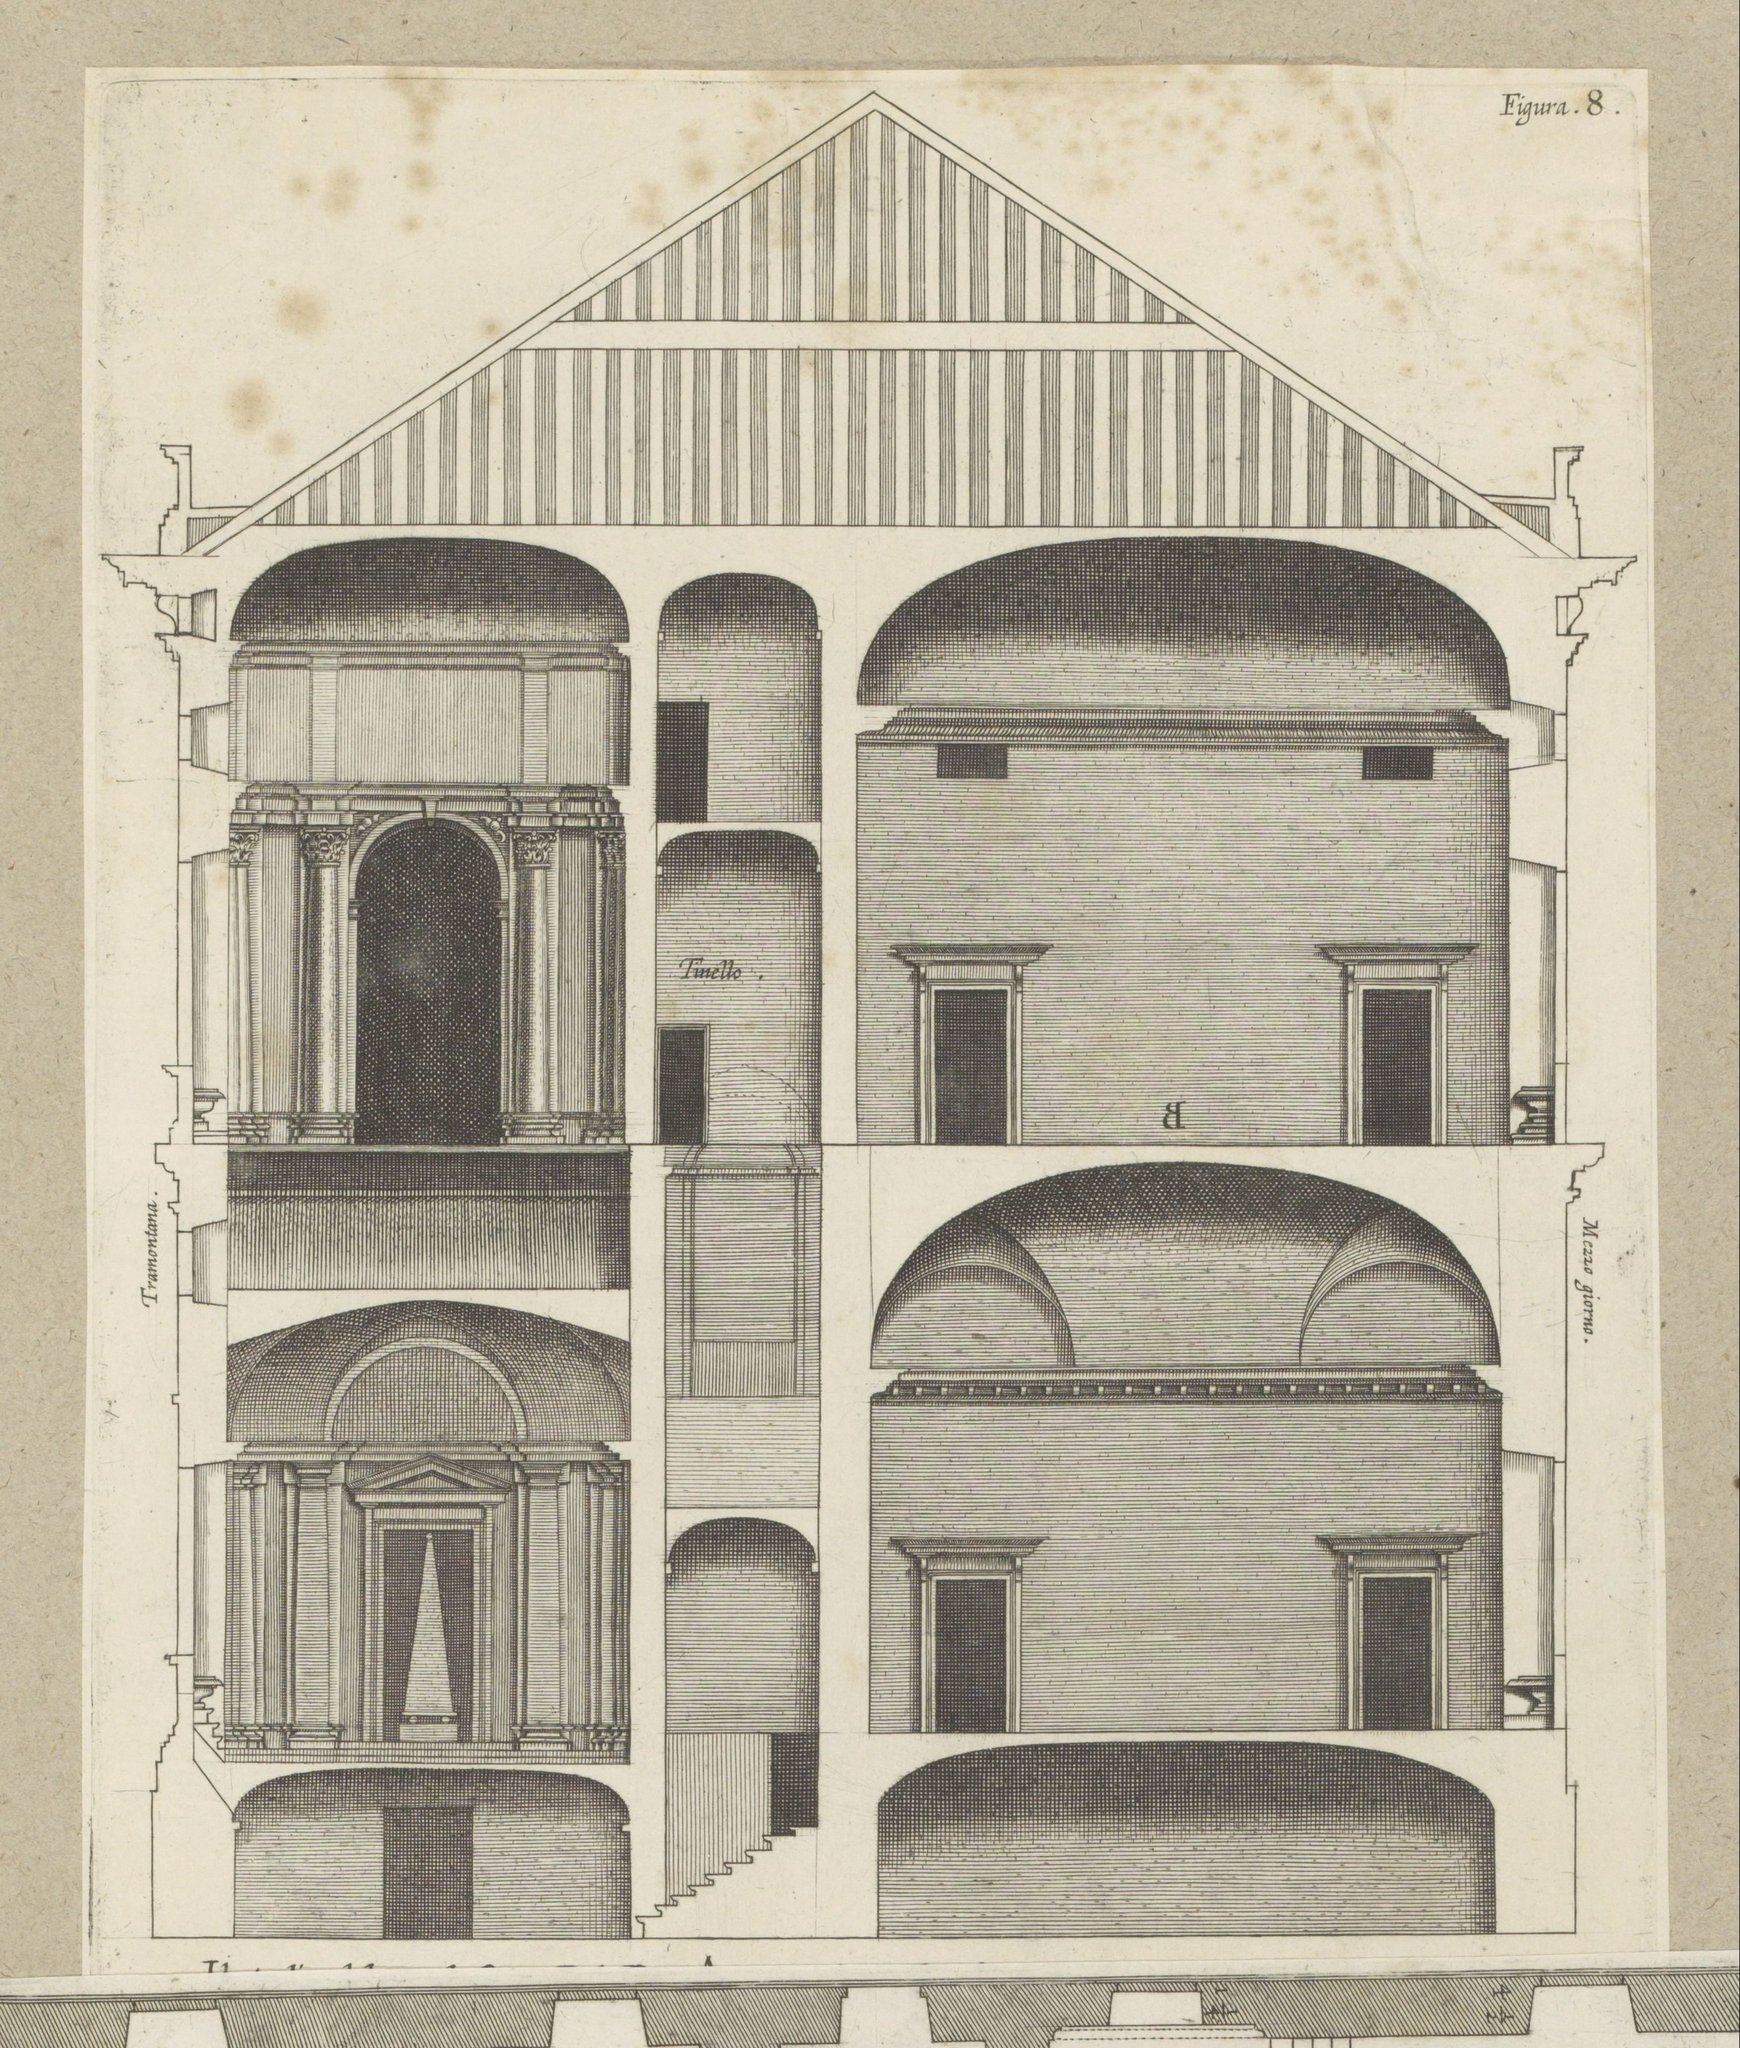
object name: album leaf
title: Langsdoorsnede van het Palazzo Carrega-Cataldi te Genua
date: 1622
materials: paper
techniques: engraving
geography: antwerp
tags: hôtel, i.e. small palace in city - aa - civic architecture: inside, section ~ architectural design or model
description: Deze prent maakt deel uit van een album.